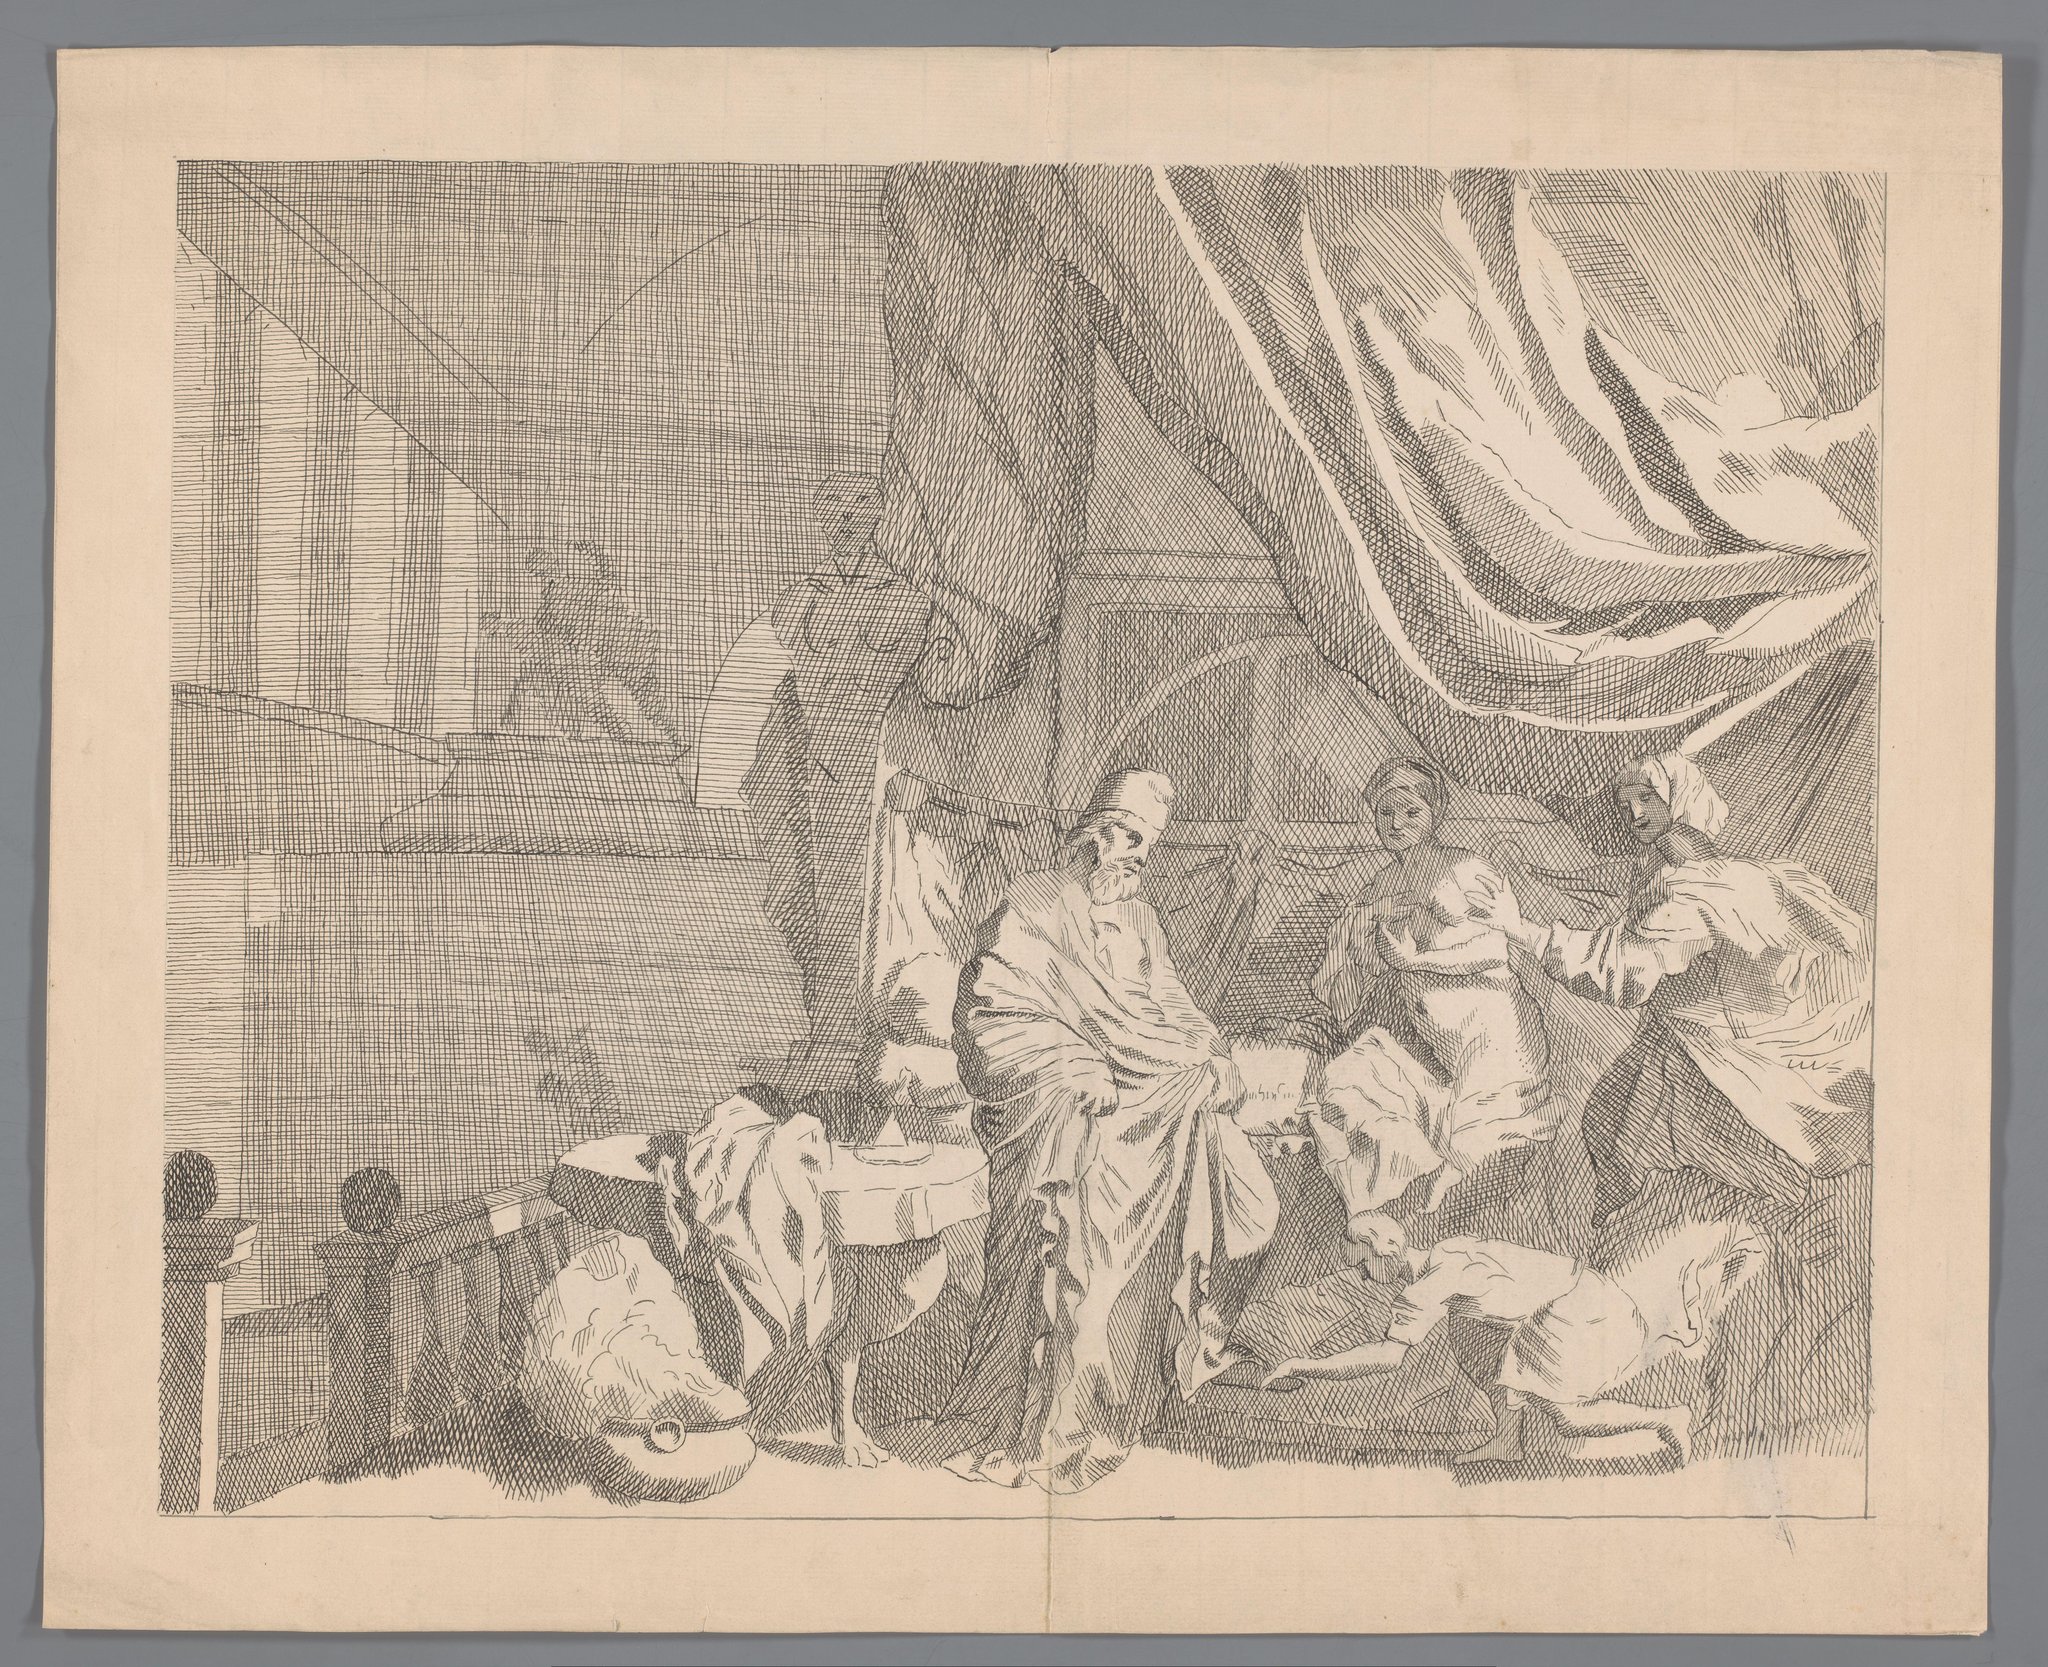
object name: drawing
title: Man en naakte vrouw in een slaapvertrek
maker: Anonymous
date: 1700-1799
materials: ink, paper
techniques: pen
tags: the (nude) human figure; 'corpo humano' (ripa) - aa - female human figure, bedroom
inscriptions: collector's mark: Lugt 240, number: ‘4’, annotation: ‘30, 2. - a’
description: Een naakte vrouw zit op een bed in een slaapvertrek. Rechts van haar komt een vrouw aangesneld met uitgestrekte armen. Op de vloer knielt een jongen voor een oudere man die naast het bed staat.